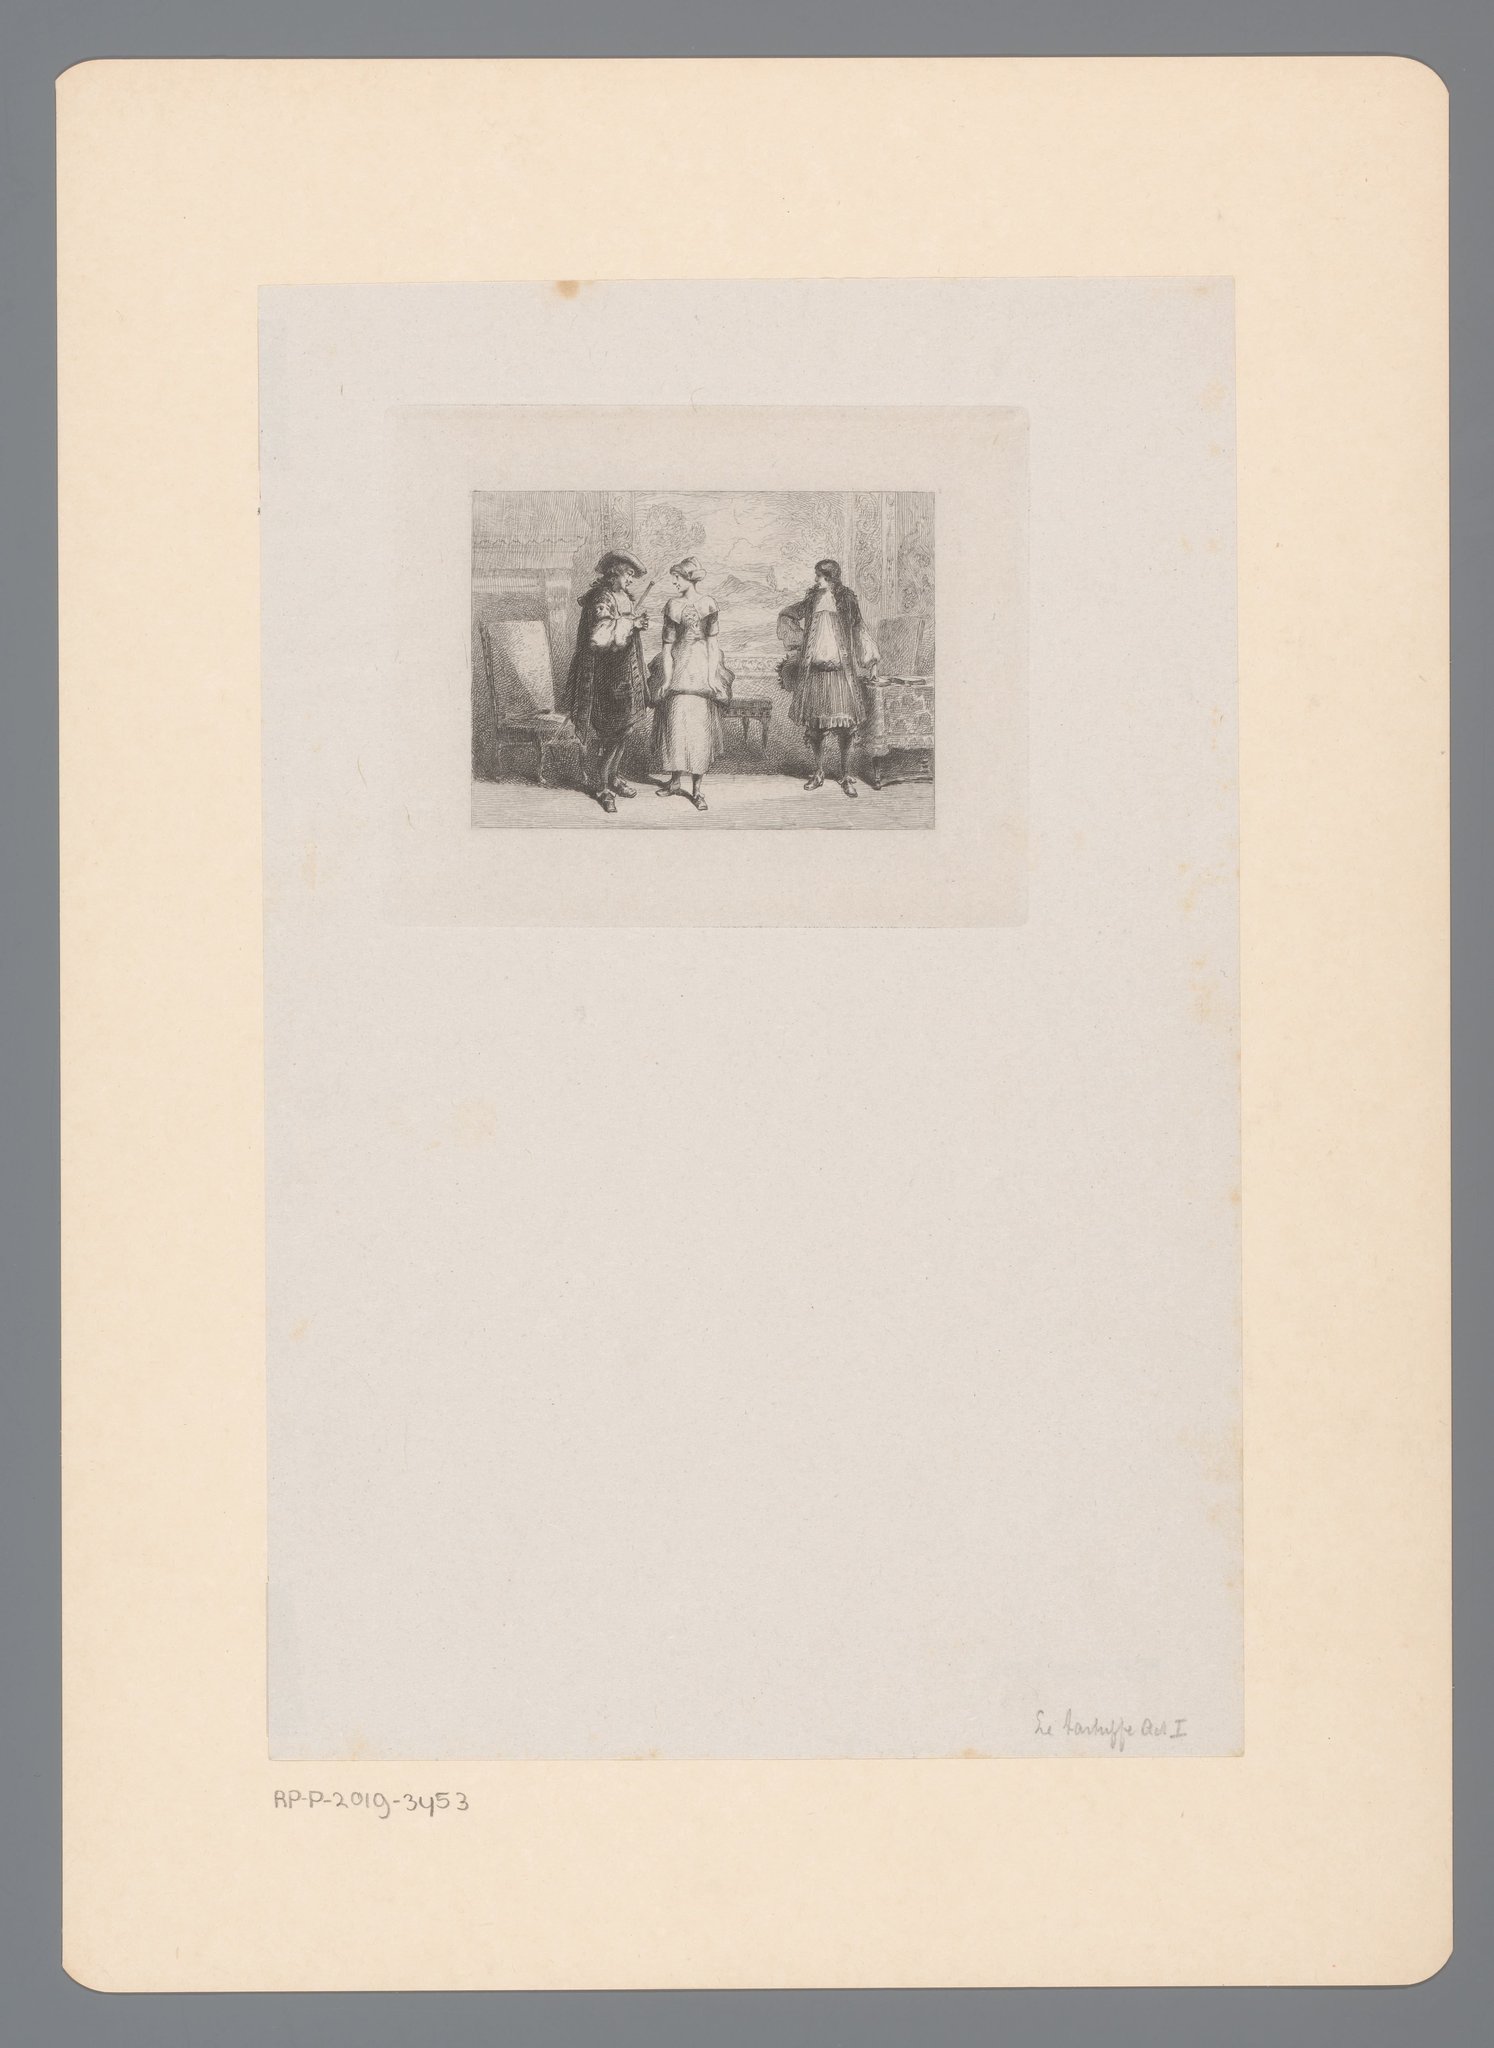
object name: print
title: Orgon in gesprek met Dorine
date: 1878-1879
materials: paper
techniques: drypoint, etching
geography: tours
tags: theatre, theatrical performance, interior of the house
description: Akte I, scène IV uit "Le Tartuffe" van Molière. Orgon in gesprek met dienstmeid Dorine over het welzijn van Tartuffe. Rechts staat Cléante.